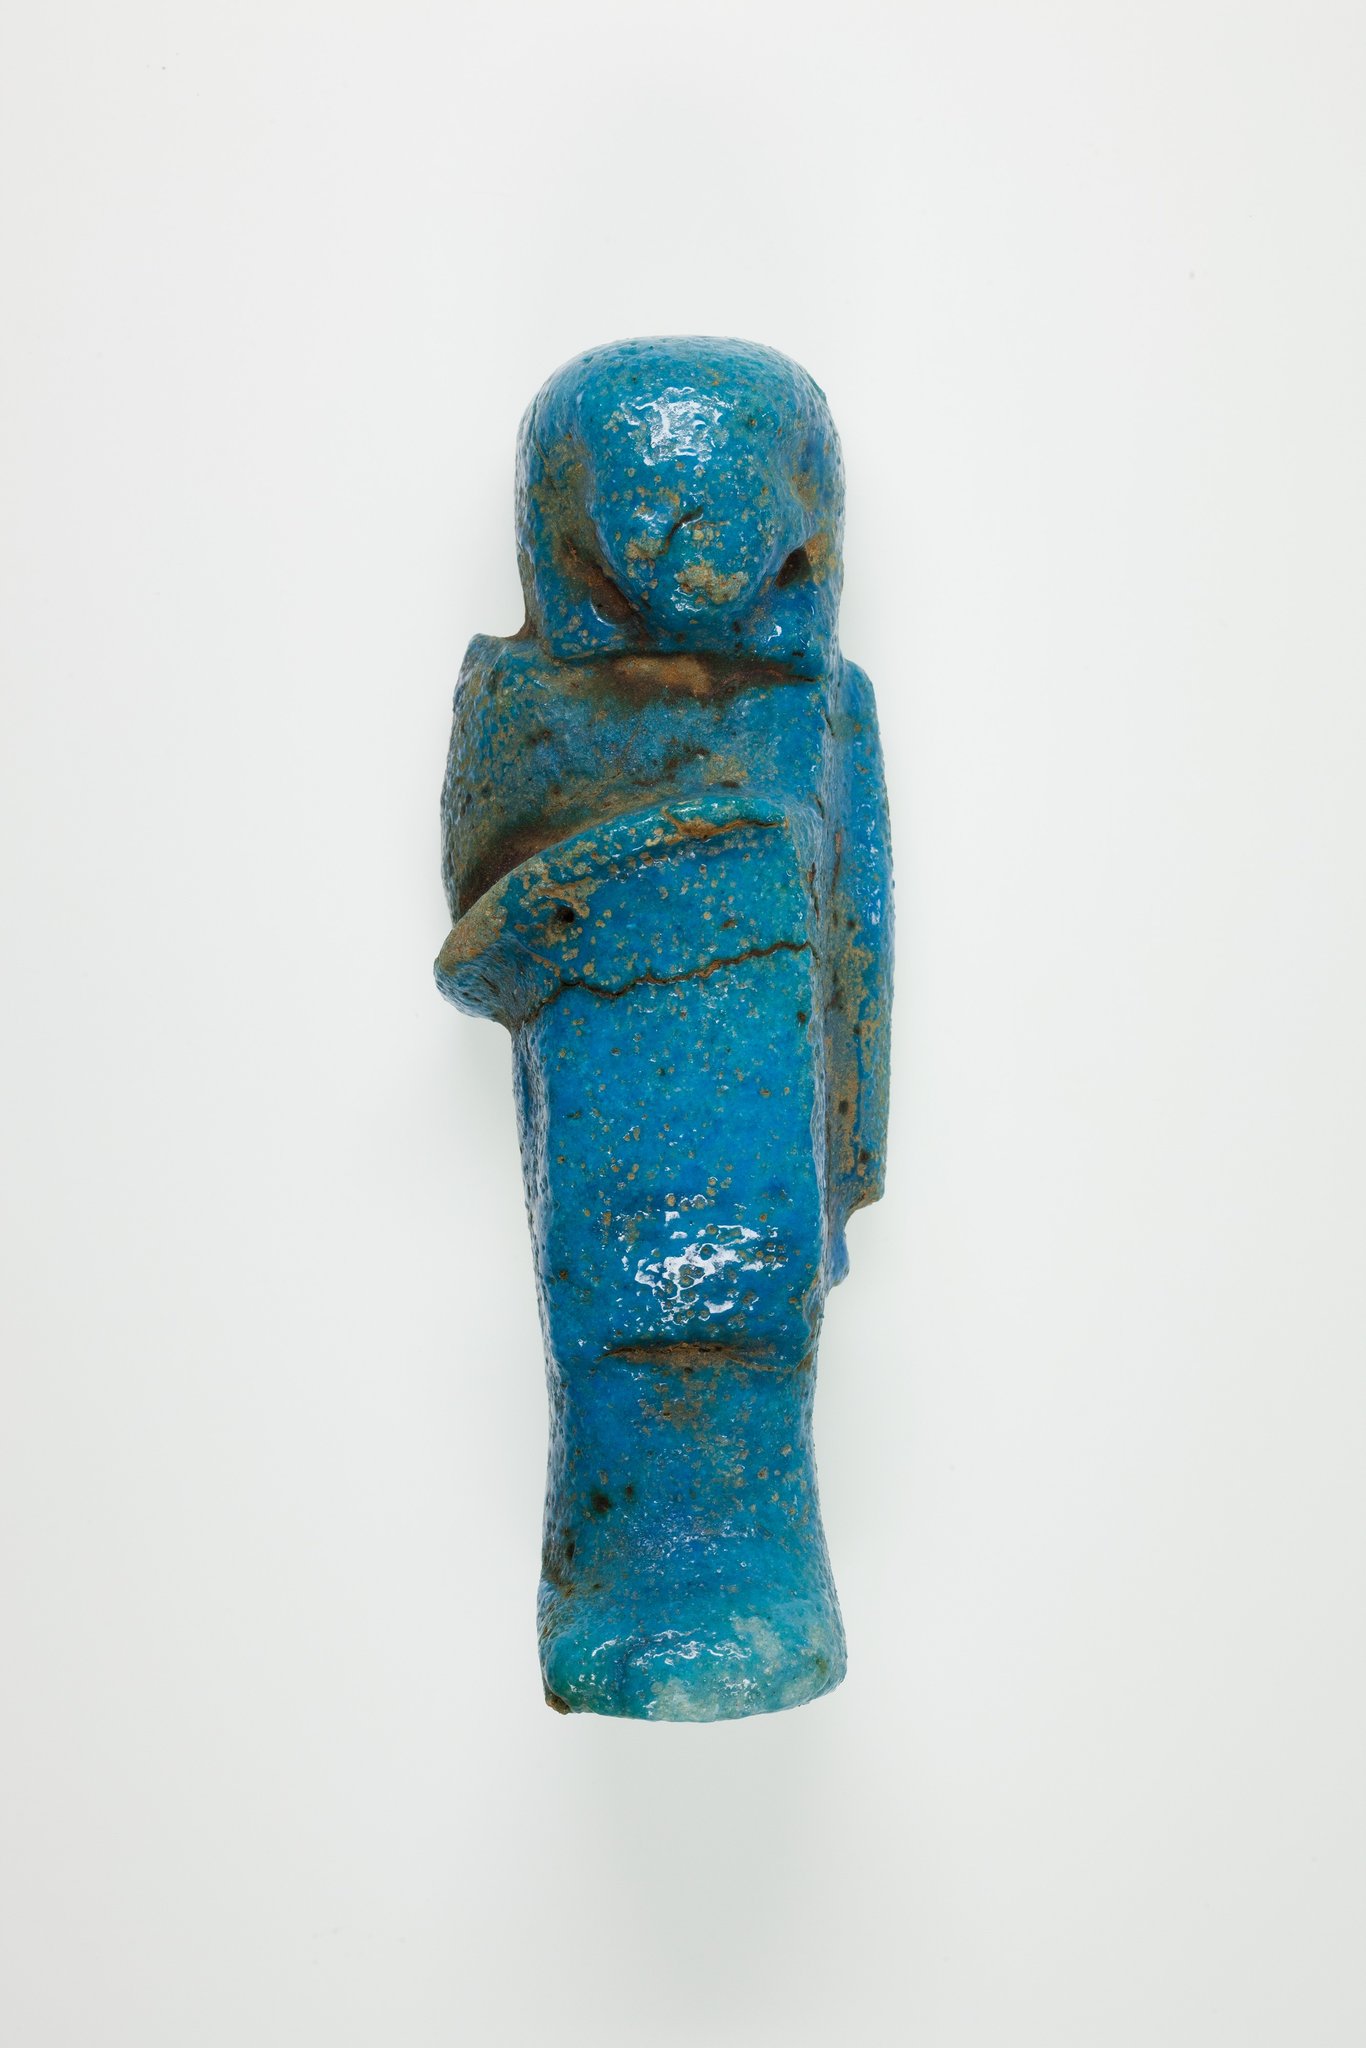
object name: overseer shabti, henettawy c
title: Overseer Shabti of Henettawy (C), Daughter of Isetemkheb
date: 990-970 BCE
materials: faience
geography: egypt